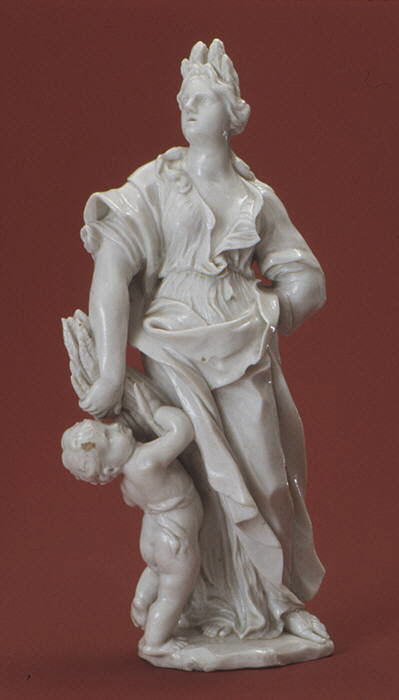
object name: figure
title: Summer (Ceres)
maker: doccia porcelain manufactory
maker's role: manufactory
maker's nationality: italian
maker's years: 1737-1896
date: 1760-1770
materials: hard paste porcelain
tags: putti,ceres